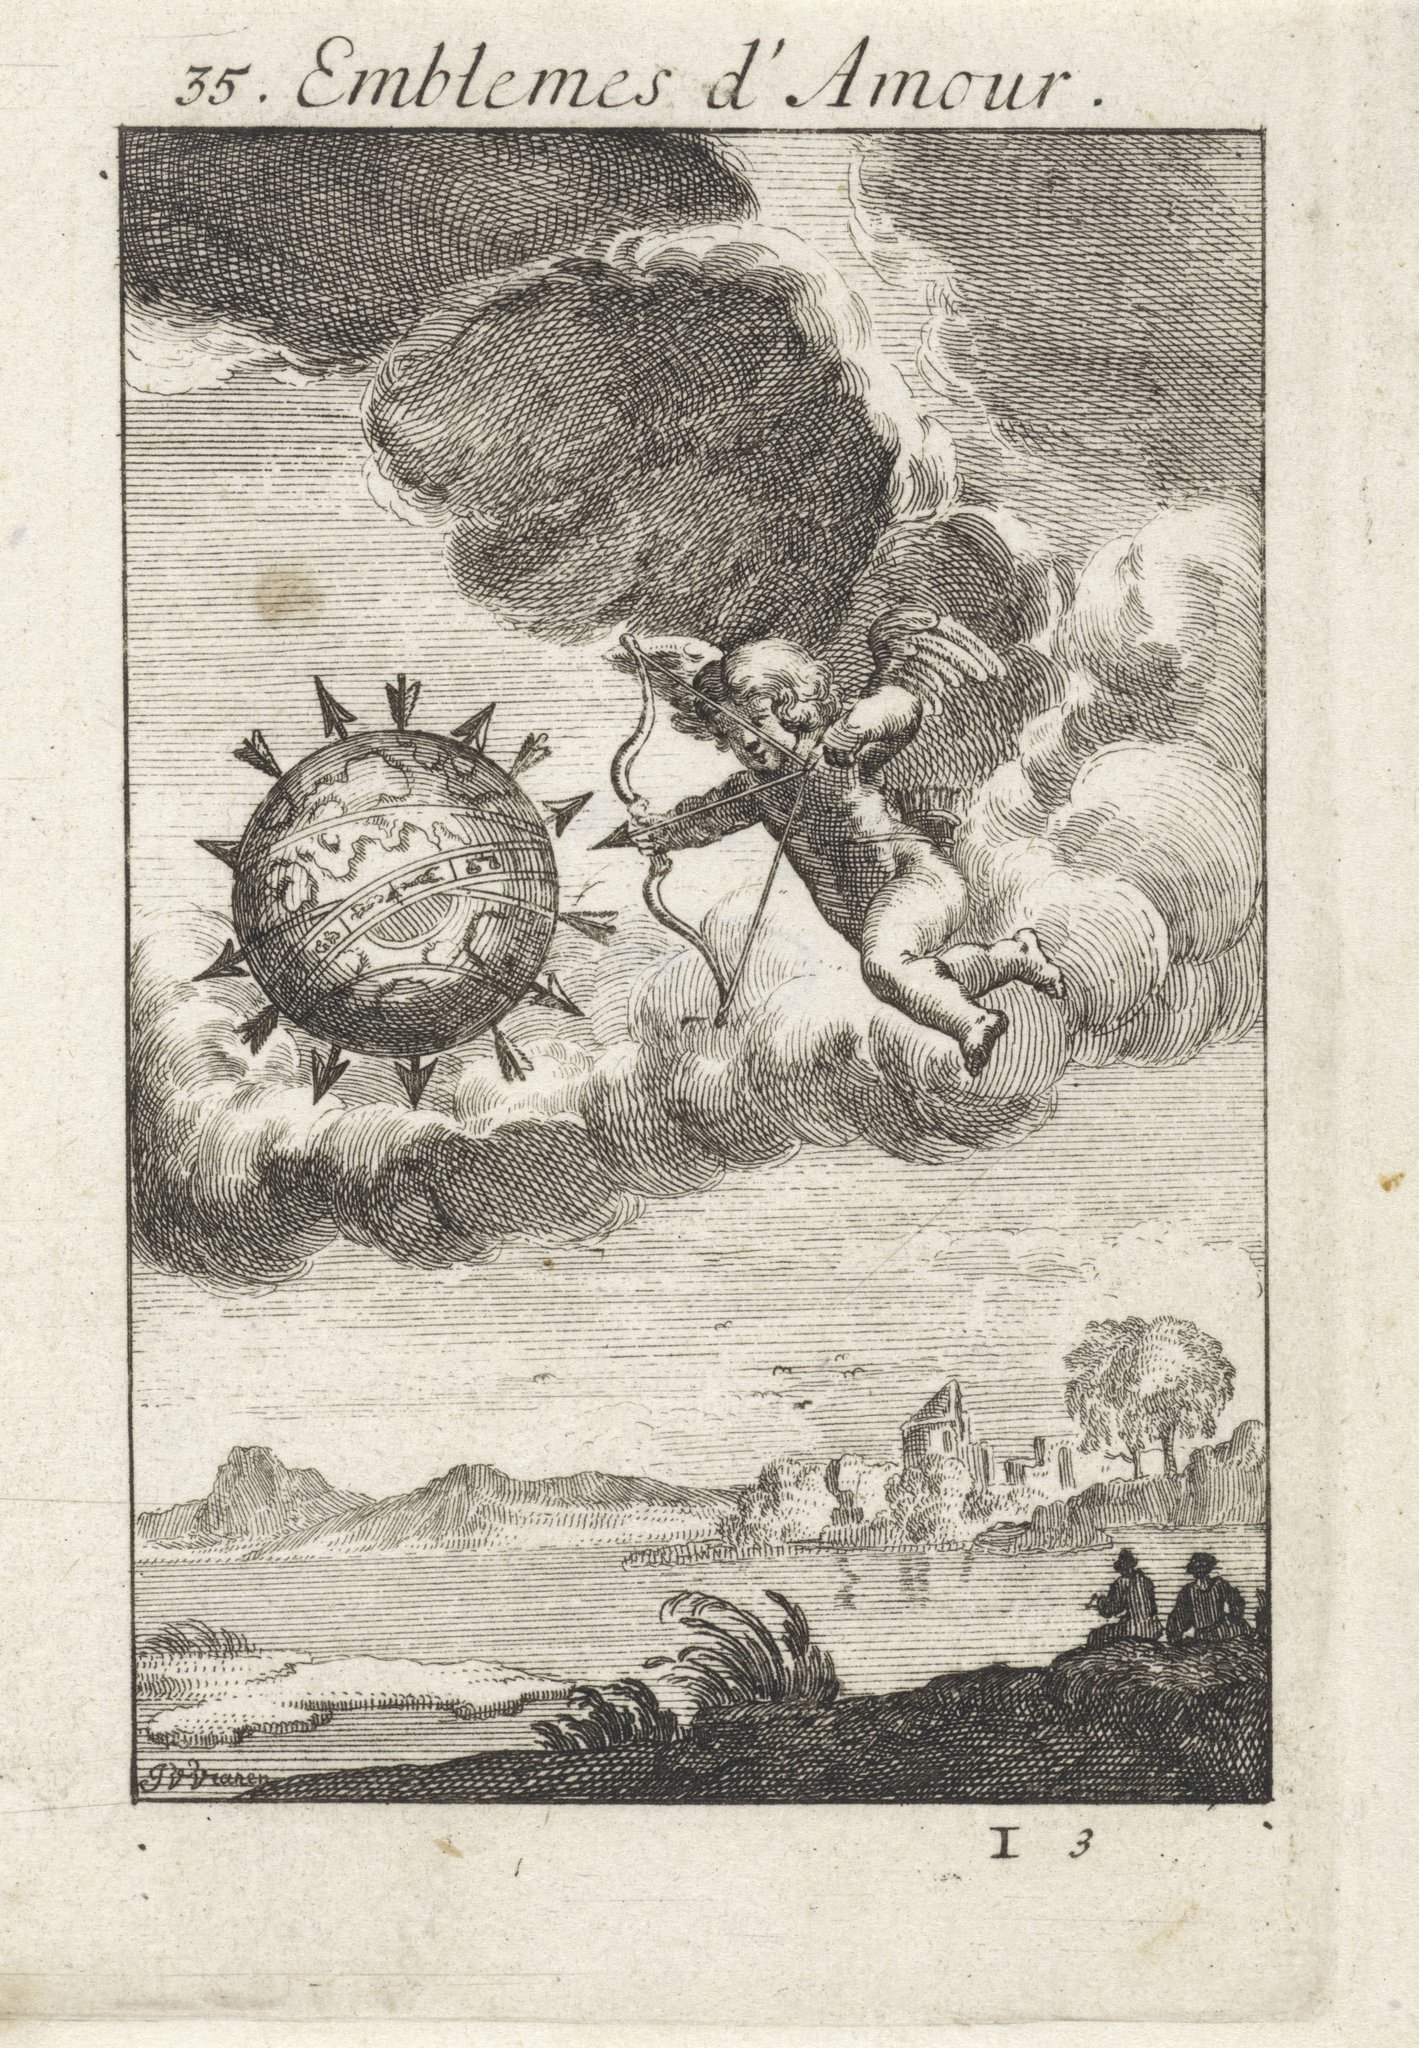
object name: print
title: Amor schiet pijlen op een aardbol met sterrenbeelden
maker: jan van vianen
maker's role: print maker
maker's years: 1660-1726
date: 1686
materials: paper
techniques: etching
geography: northern netherlands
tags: cupid shooting a dart, (story of) cupid, amor (eros), globe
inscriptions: collector's mark: Lugt 2228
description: Amor schiet pijlen op een aardbol met een band met tekens van de dierenriem, tussen de wolken boven een rivierlandschap. De liefde bindt alles. Vijfendertigste embleem uit Emblemata Amatoria.